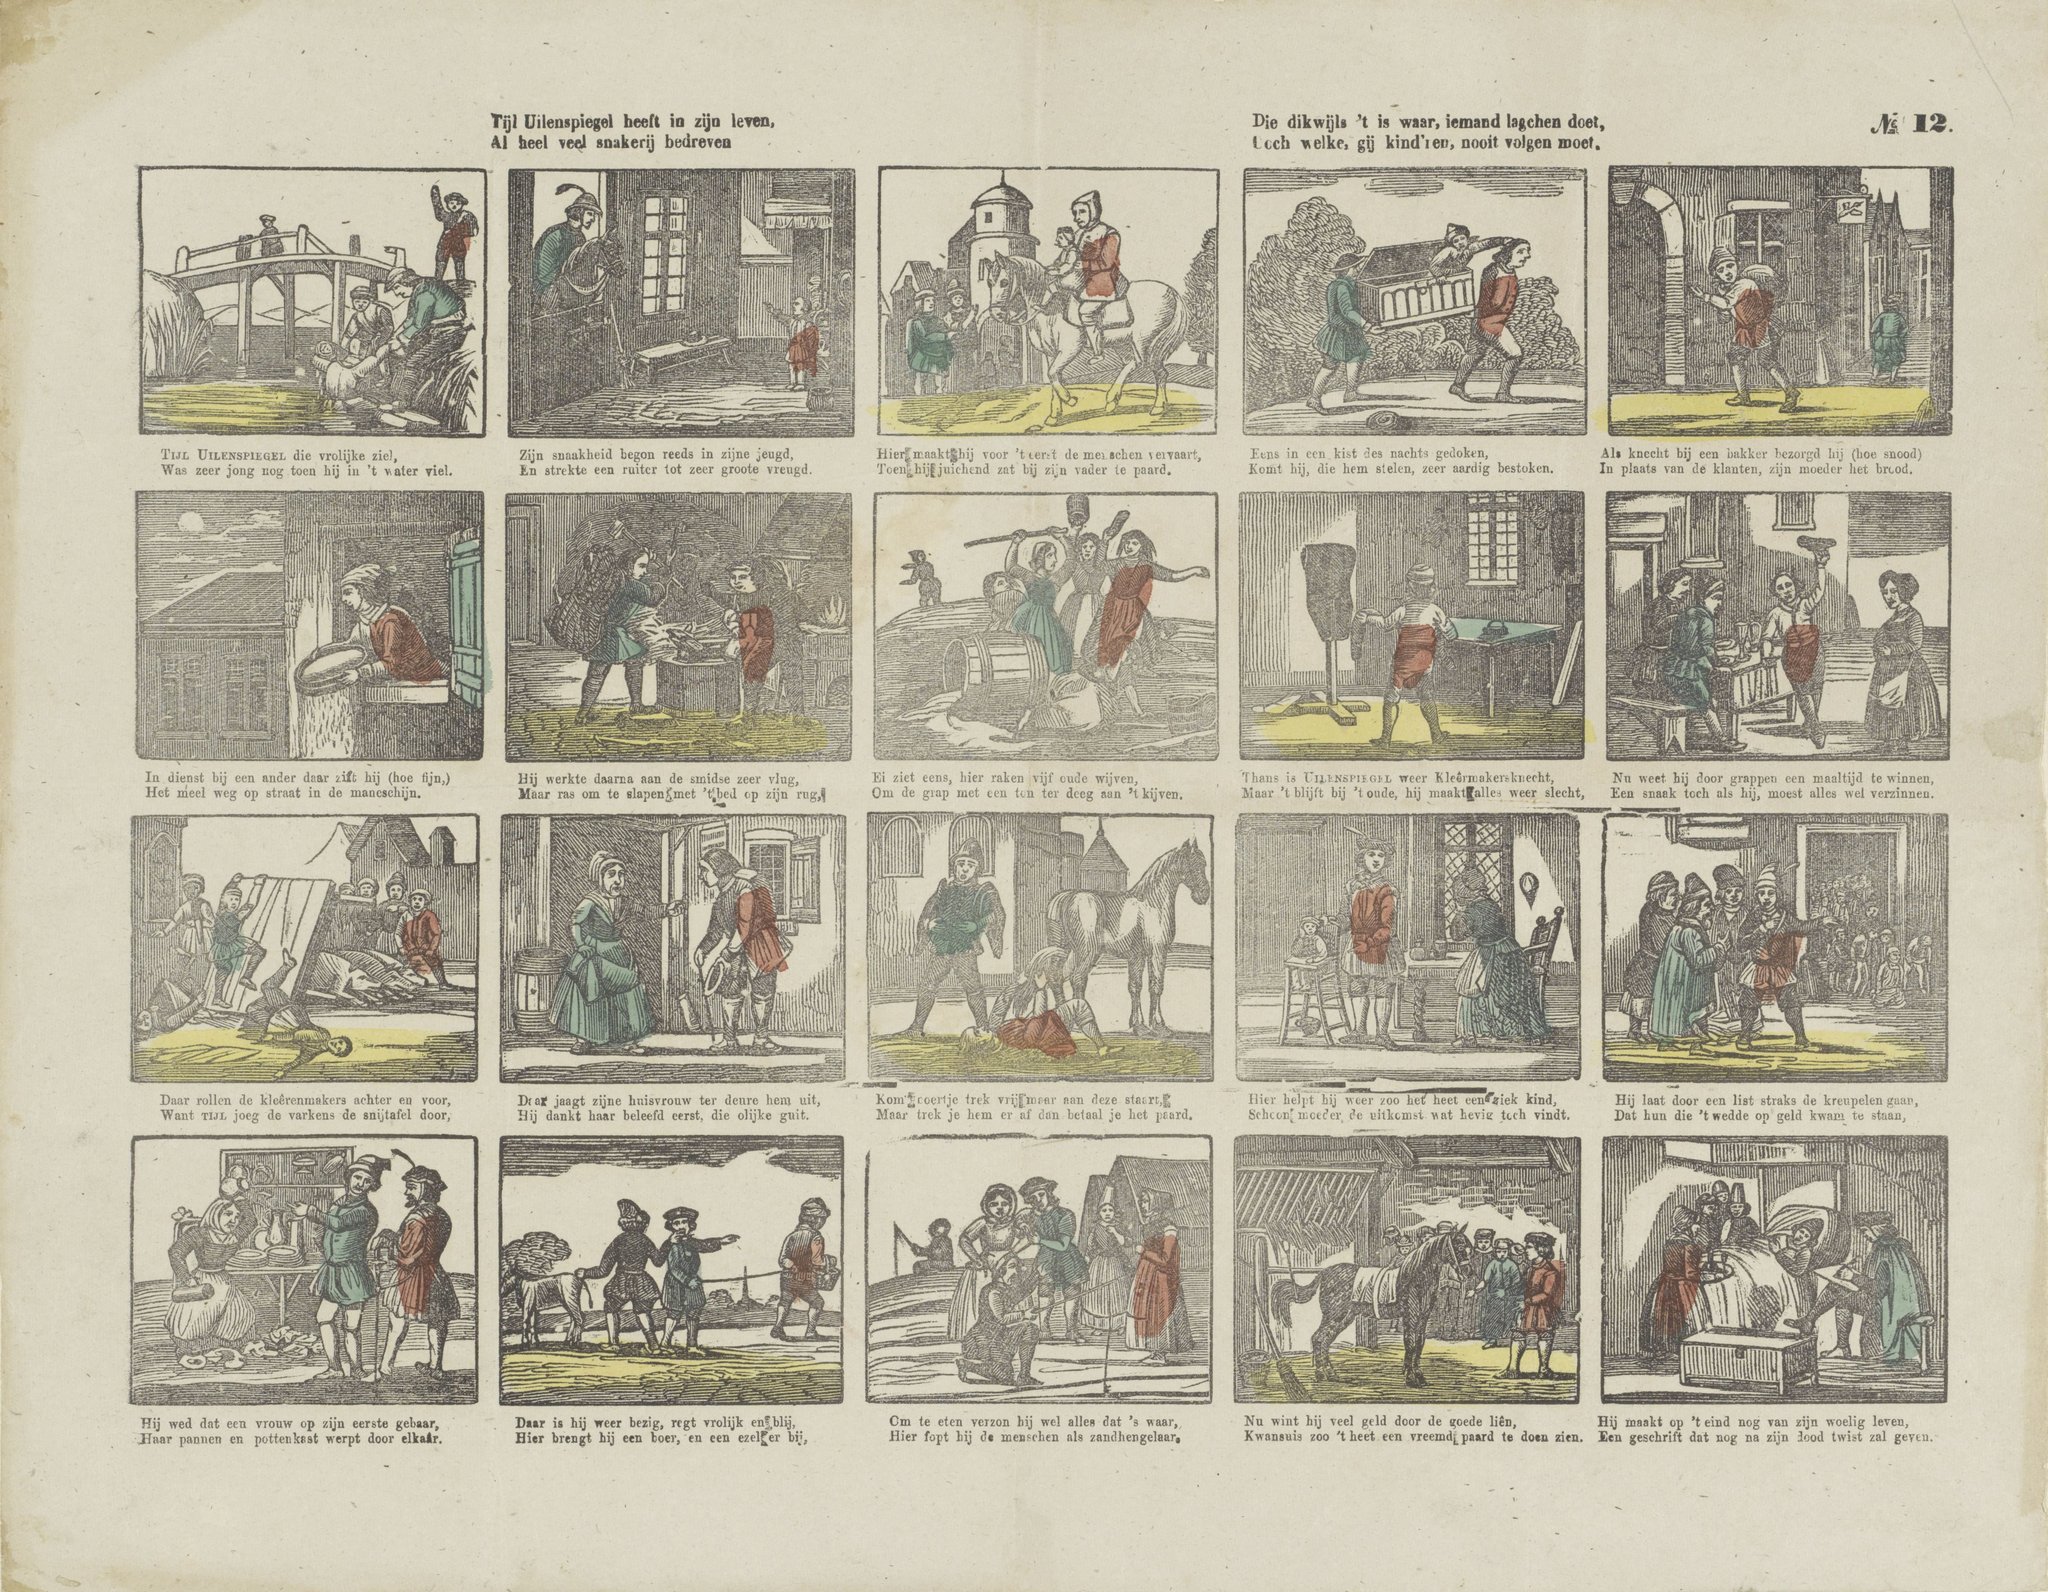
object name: print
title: Tijl Uilenspiegel heeft in zijn leven, / Al heel veel snakerij bedreven / Die dikwijls 't is waar, iemand lagchen doet, / Doch welke, gij kind'ren, nooit volgen moet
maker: Anonymous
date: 1850-1870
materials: paper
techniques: colour, letterpress printing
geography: netherlands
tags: eulenspiegel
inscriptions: collector's mark: Lugt 2760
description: Blad met 20 voorstellingen over het leven van Tijl Uilenspiegel. Onder elke afbeelding een tweeregelig vers. Genummerd rechtsboven: No 12.